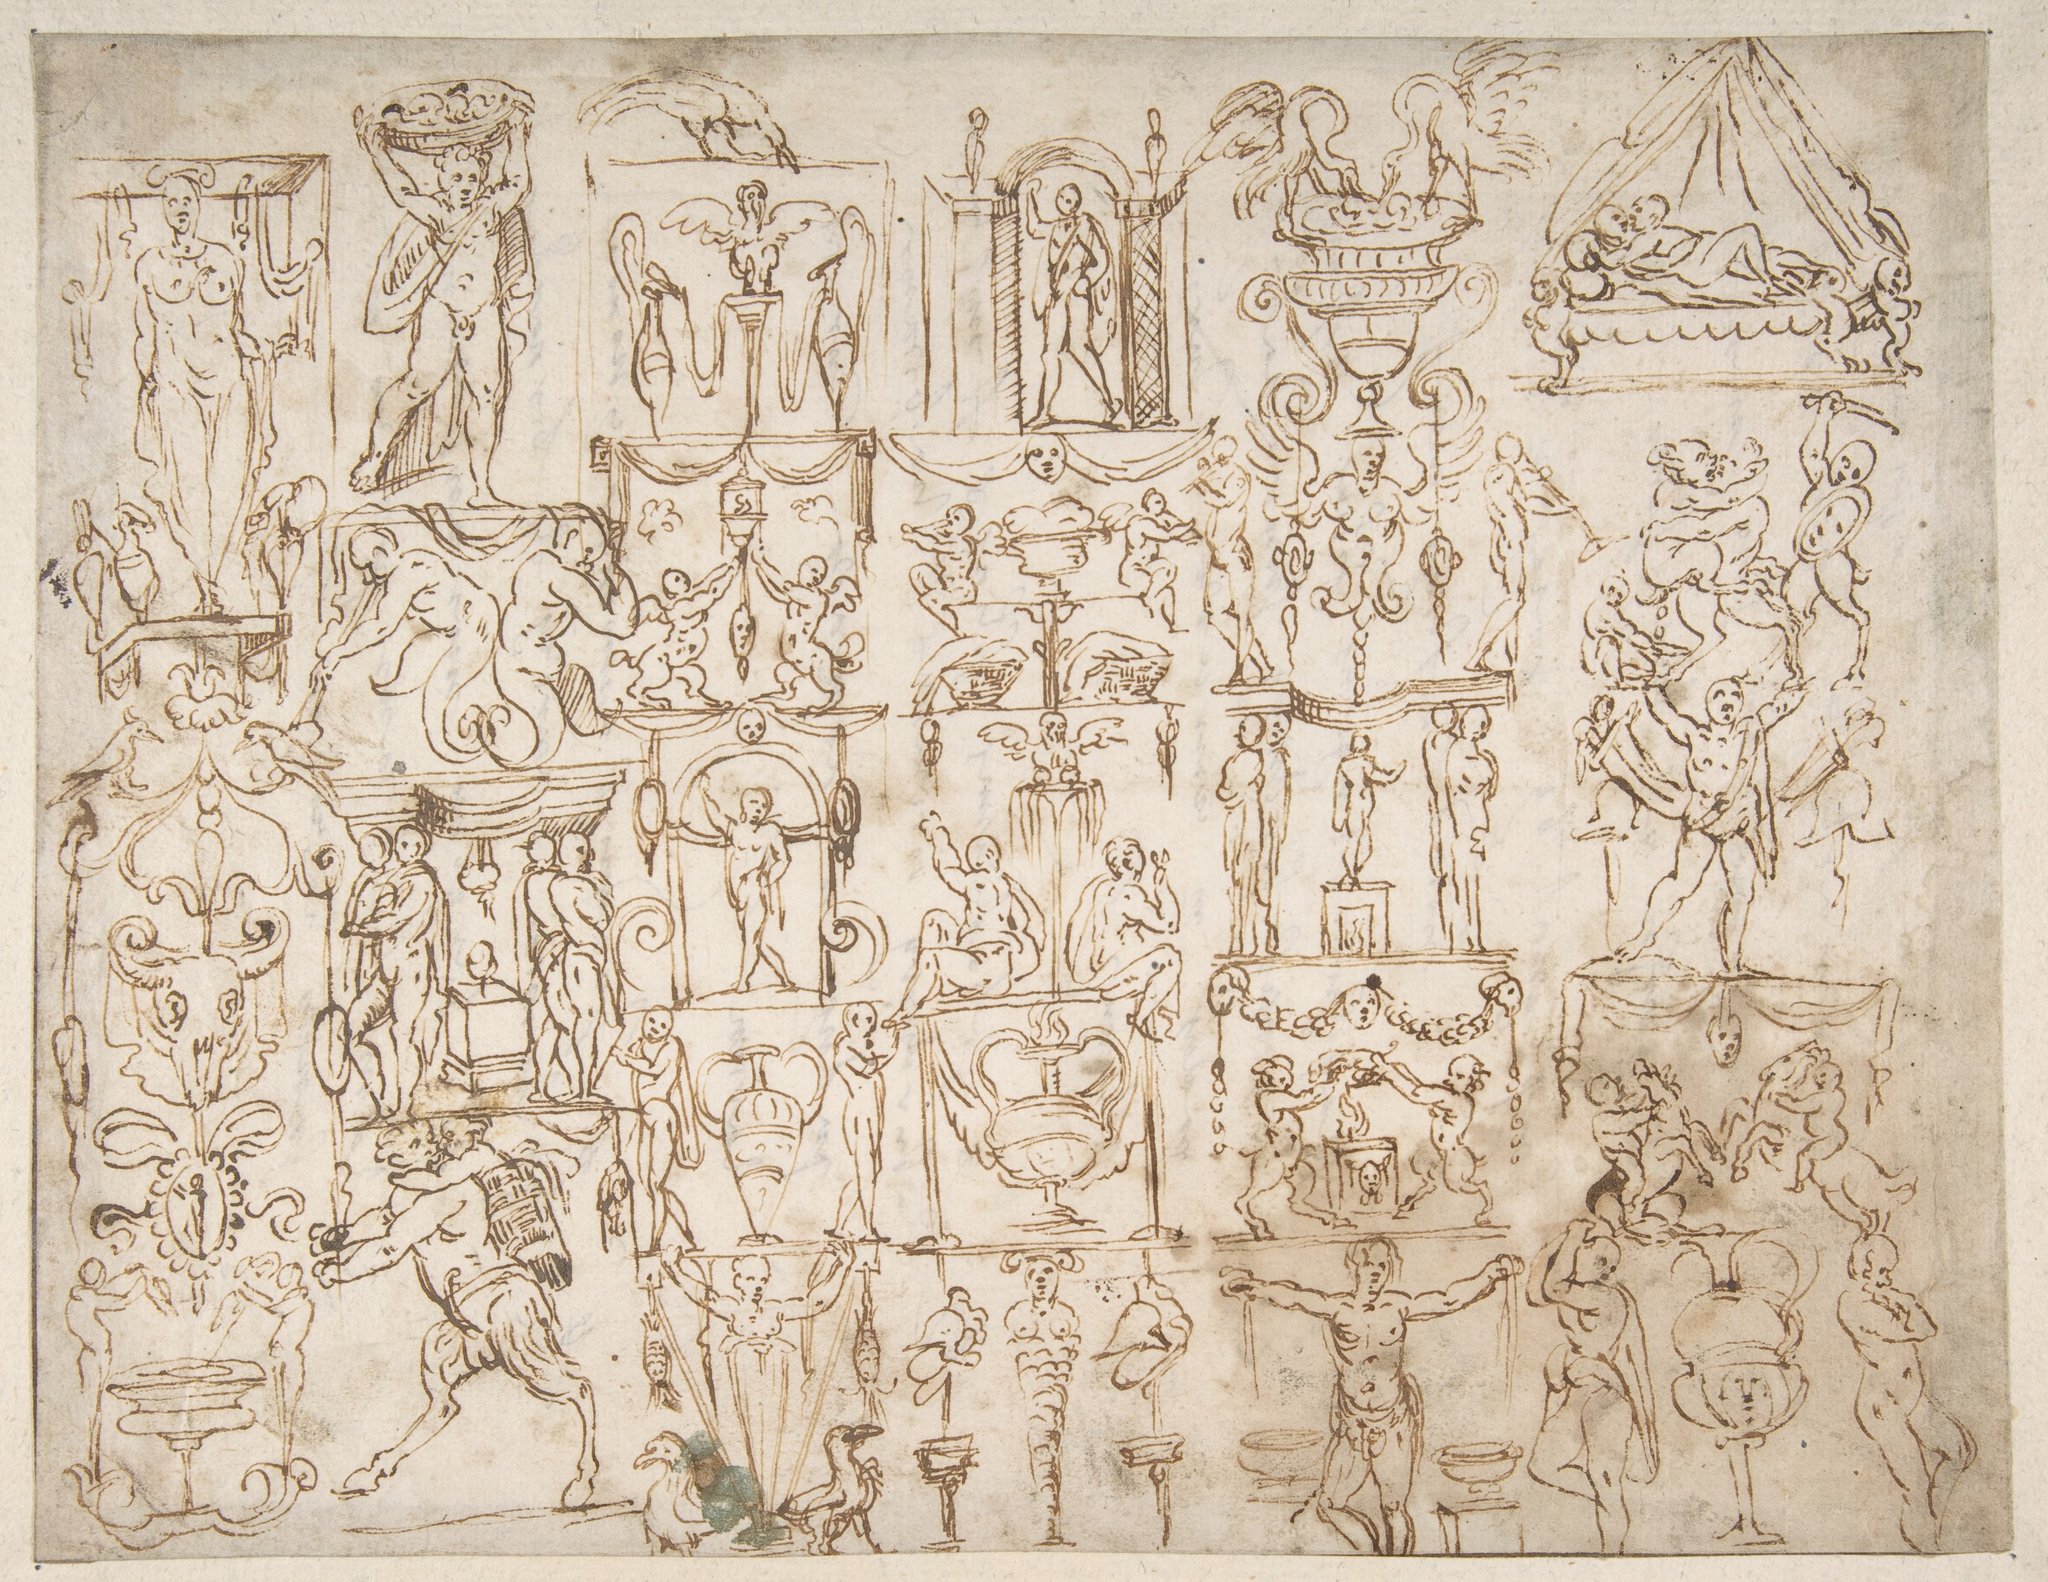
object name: drawing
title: Sketches of Grotesques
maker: giovanni antonio dosio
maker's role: artist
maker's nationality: italian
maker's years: 1533-1609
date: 1533-1609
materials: ink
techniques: pen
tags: grotesques,ornament